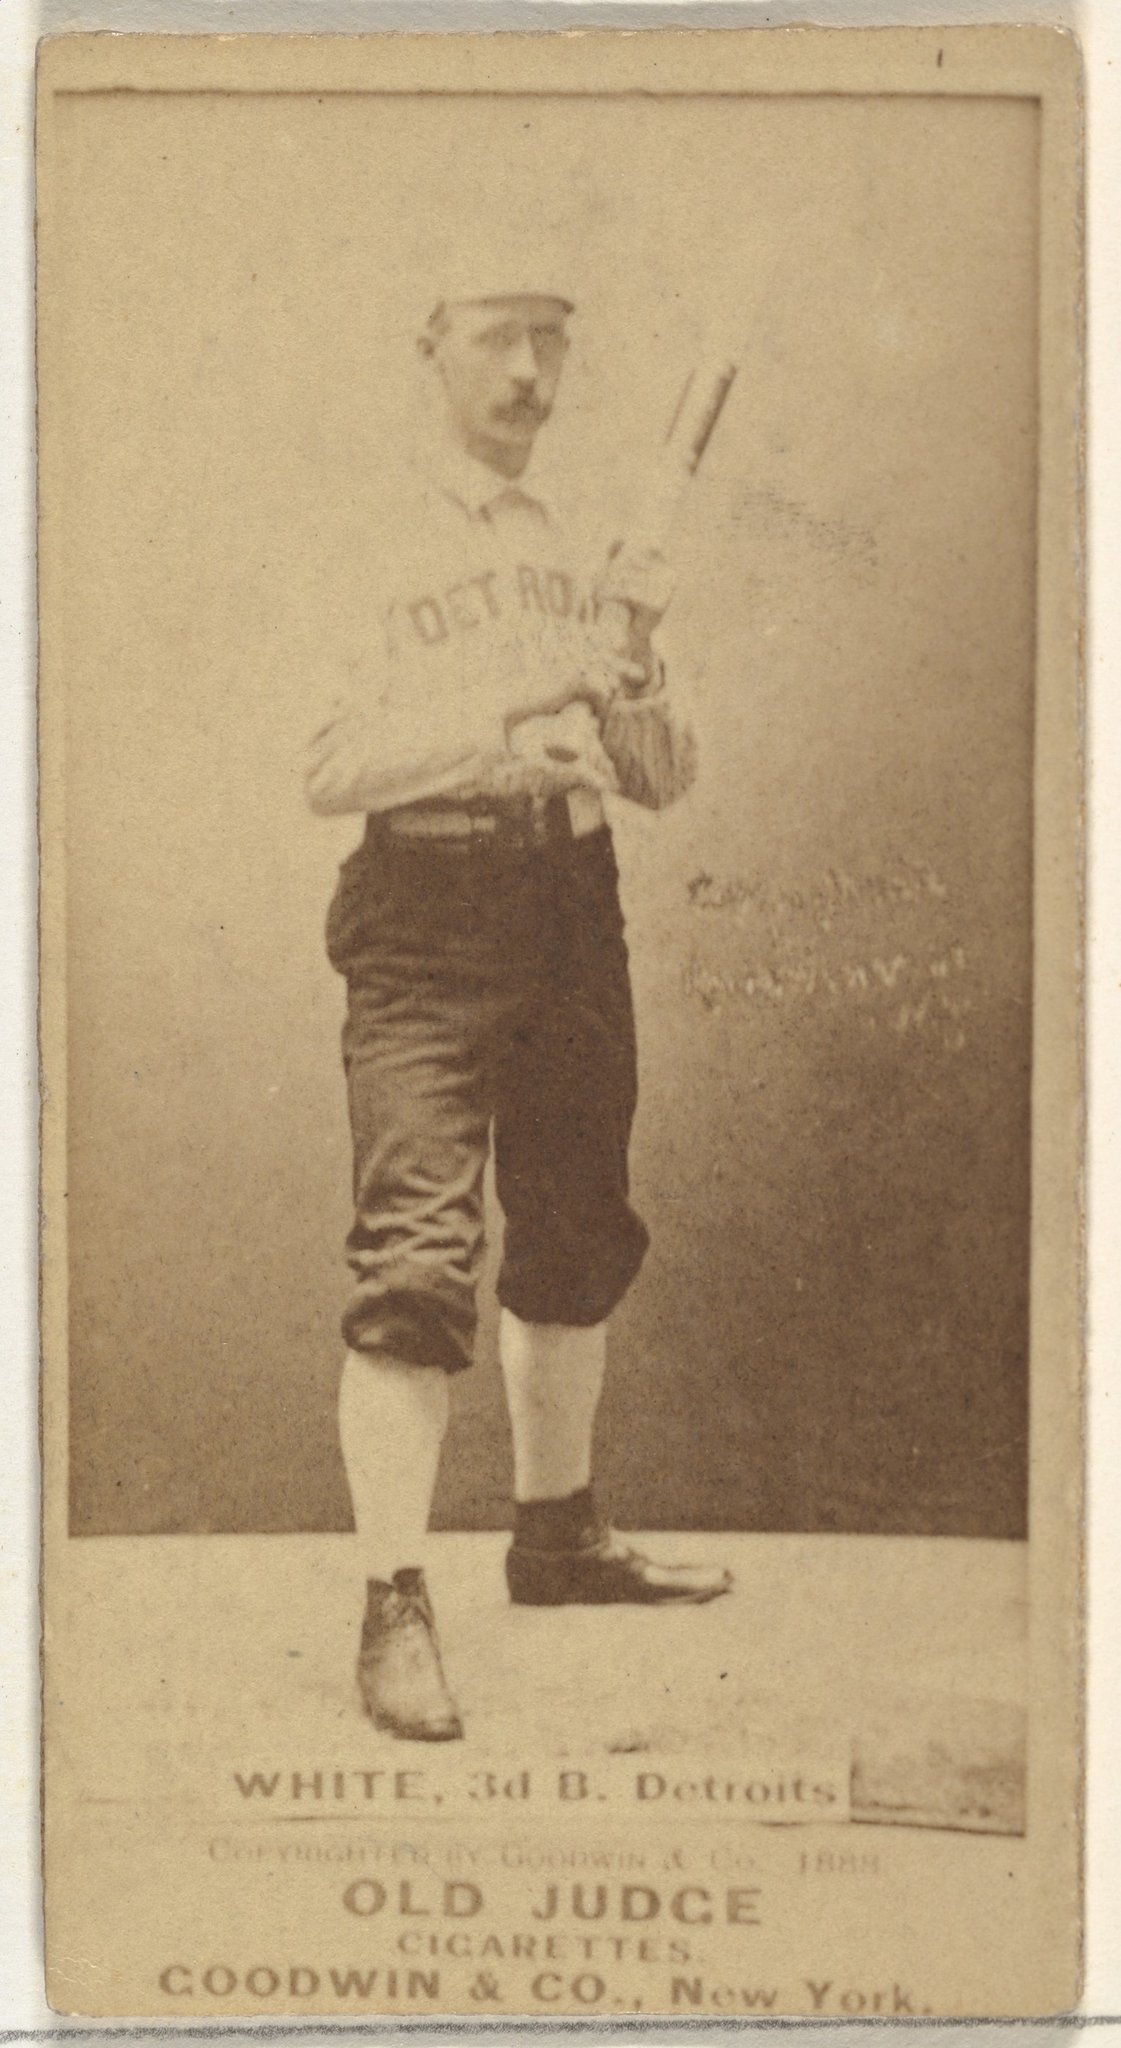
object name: baseball card, photograph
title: James Laurie "Deacon" White, 3rd Base, Detroit Wolverines, from the Old Judge series (N172) for Old Judge Cigarettes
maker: goodwin & company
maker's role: publisher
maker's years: 1850-1950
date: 1887-1889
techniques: albumen silver print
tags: men,portraits,baseball,athletes